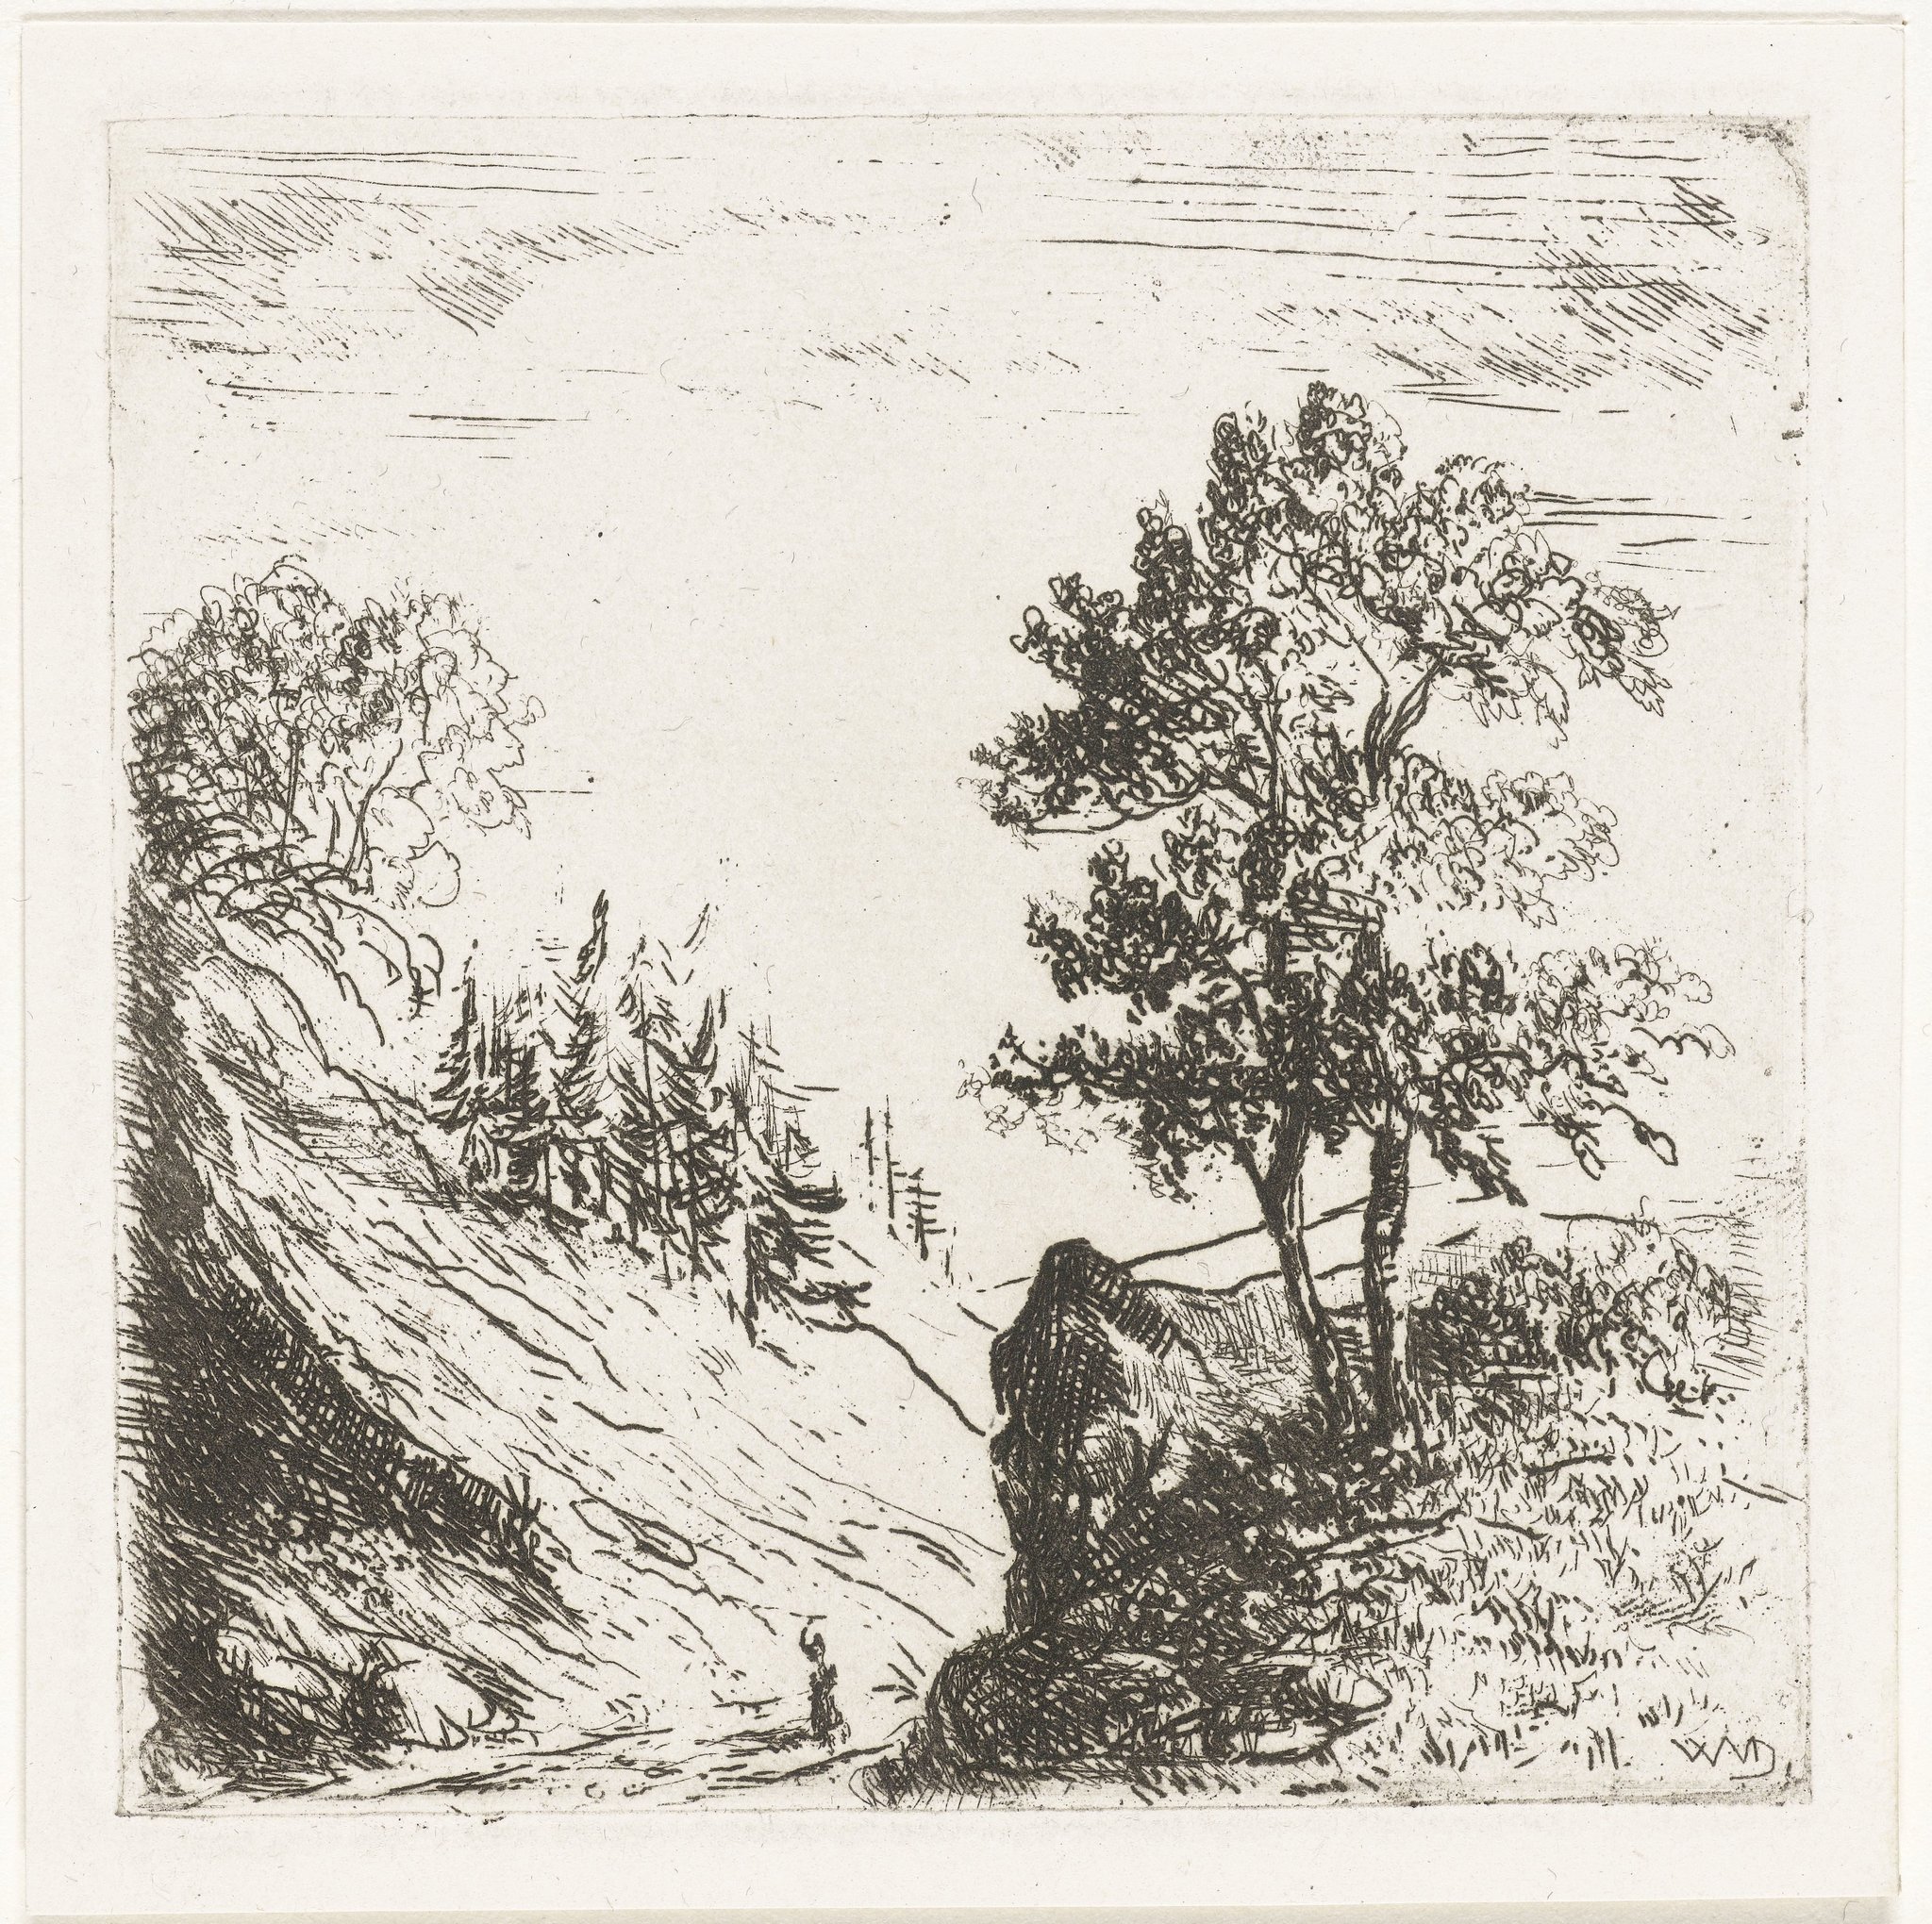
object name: print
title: Heuvellandschap met twee bomen op rots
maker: willem matthias jan van dielen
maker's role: print maker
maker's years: 1805-1867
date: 1815-1867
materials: paper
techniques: etching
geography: netherlands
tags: low hill country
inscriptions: collector's mark: Lugt 2228